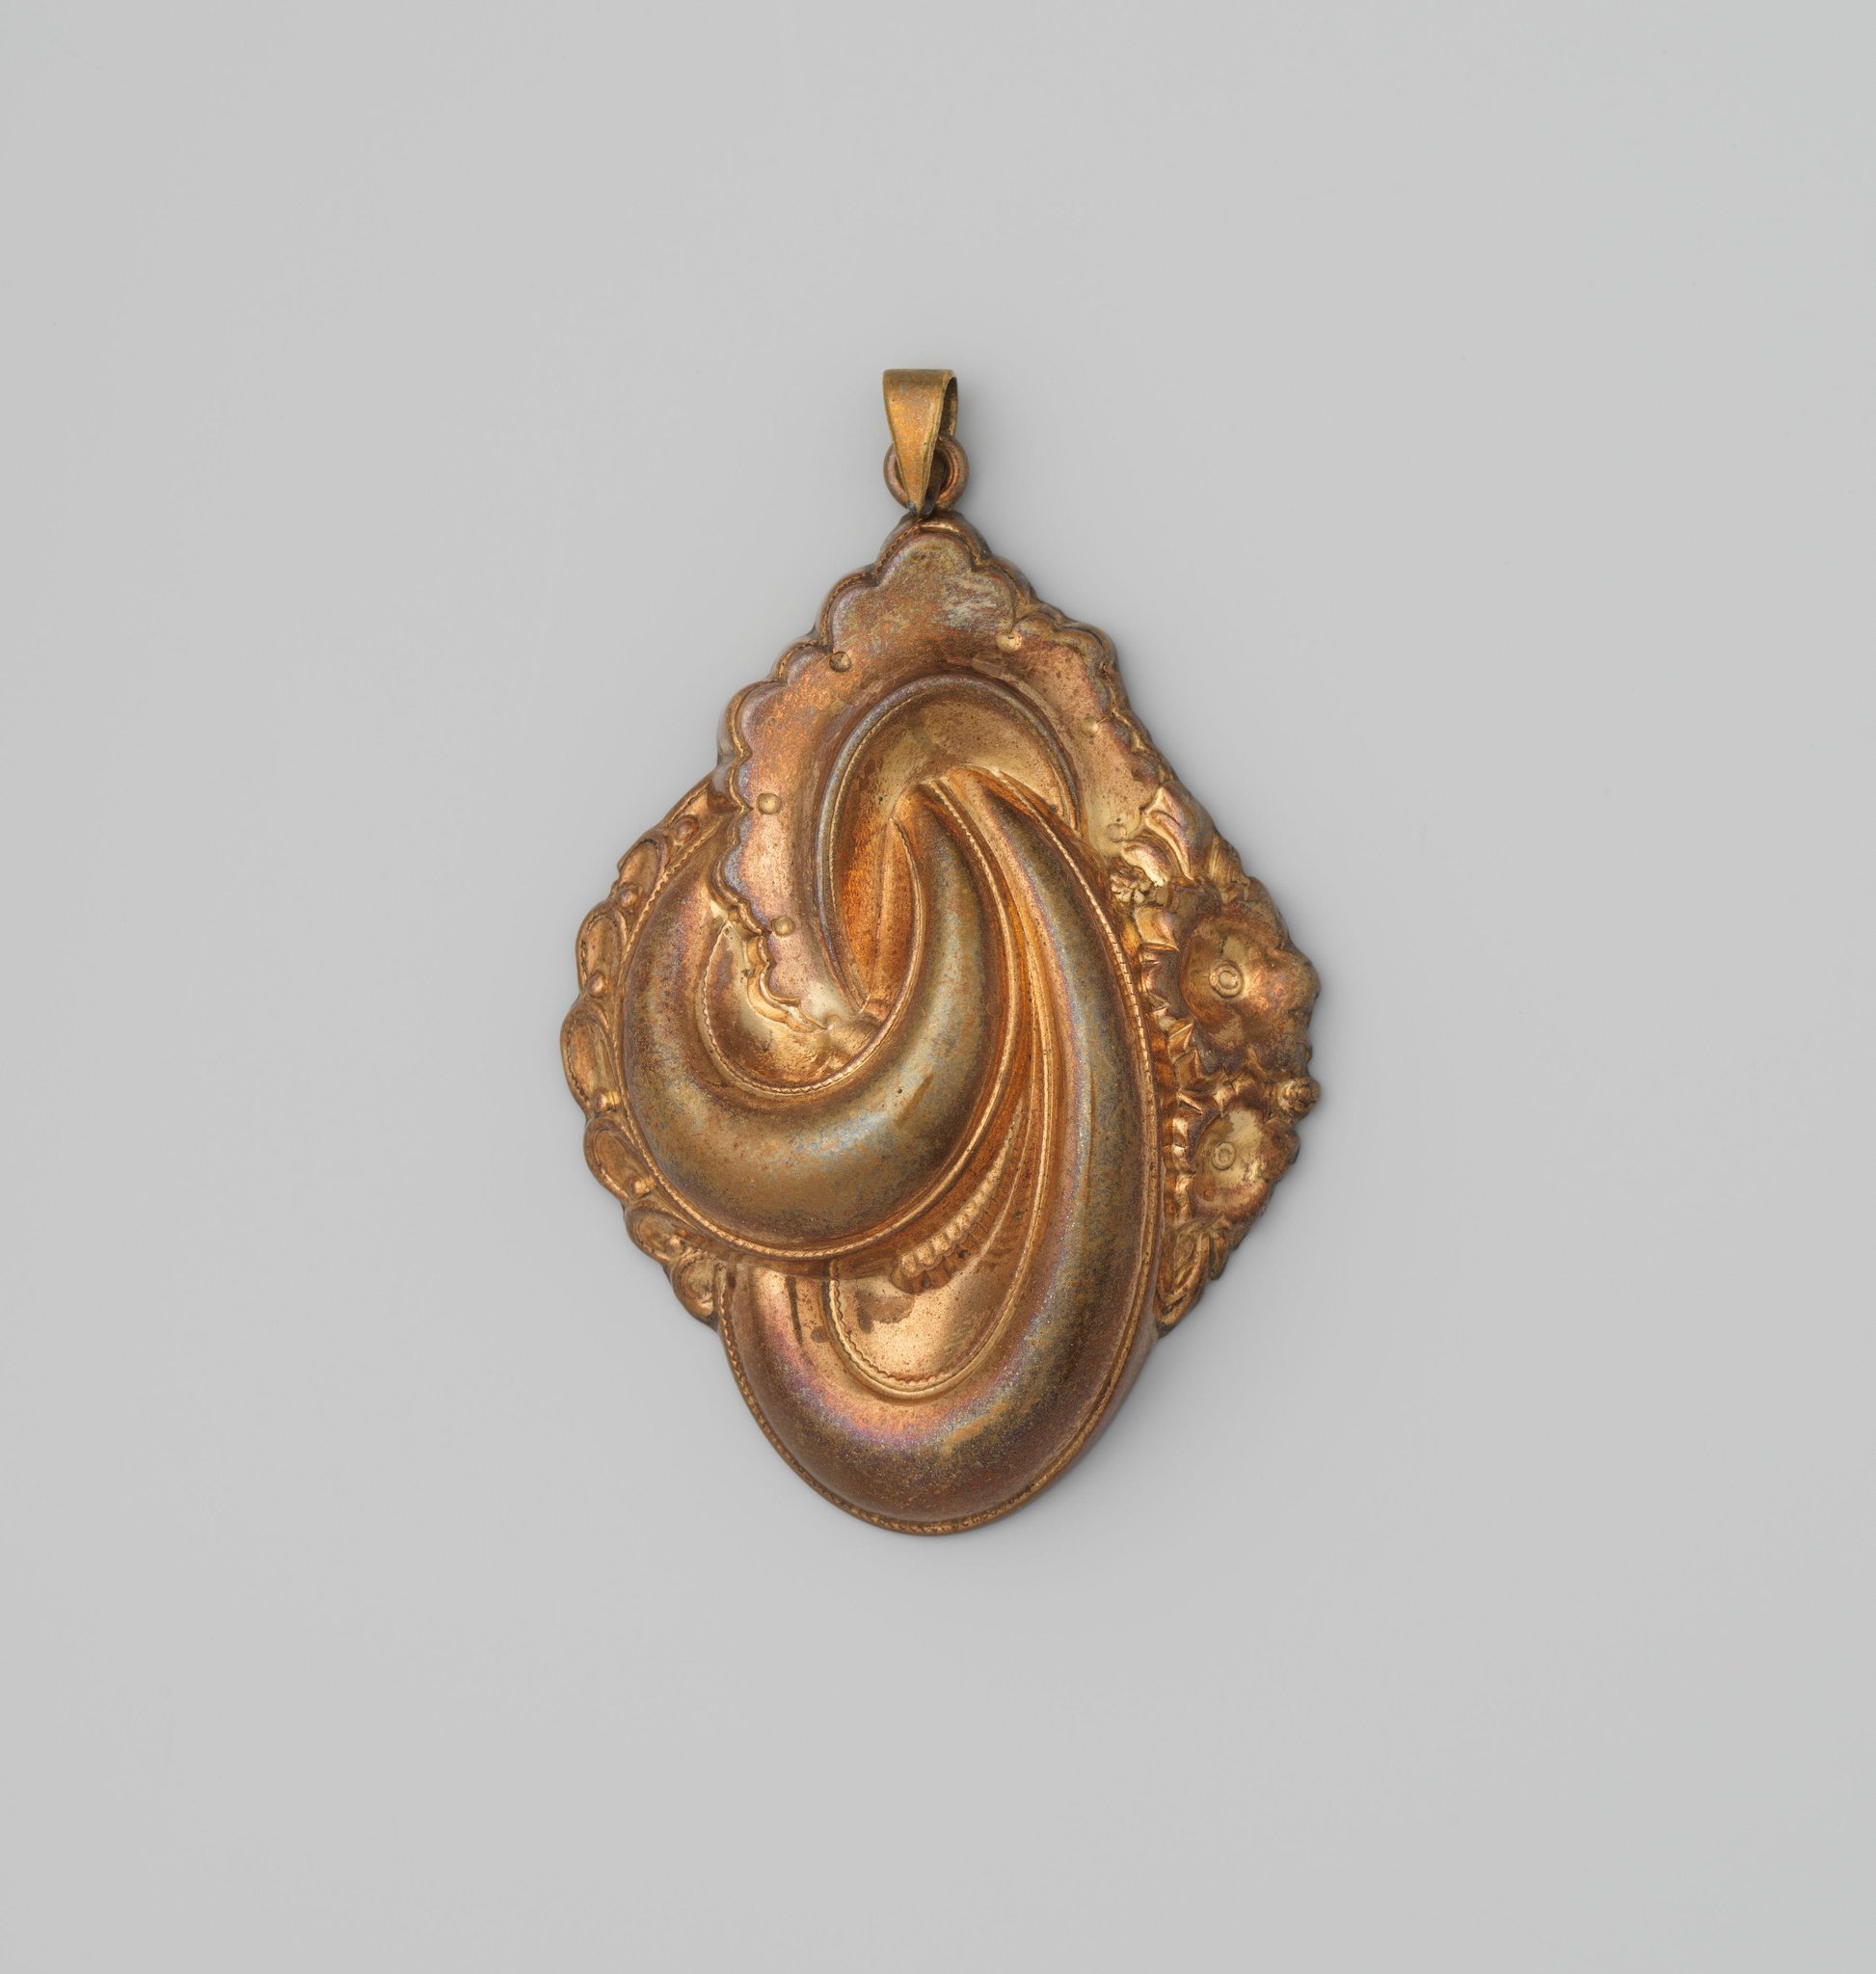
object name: pendant jewelry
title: Hanger van verguld koper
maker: Anonymous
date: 1860-1880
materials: copper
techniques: gilding, repoussé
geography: netherlands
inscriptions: alloy mark